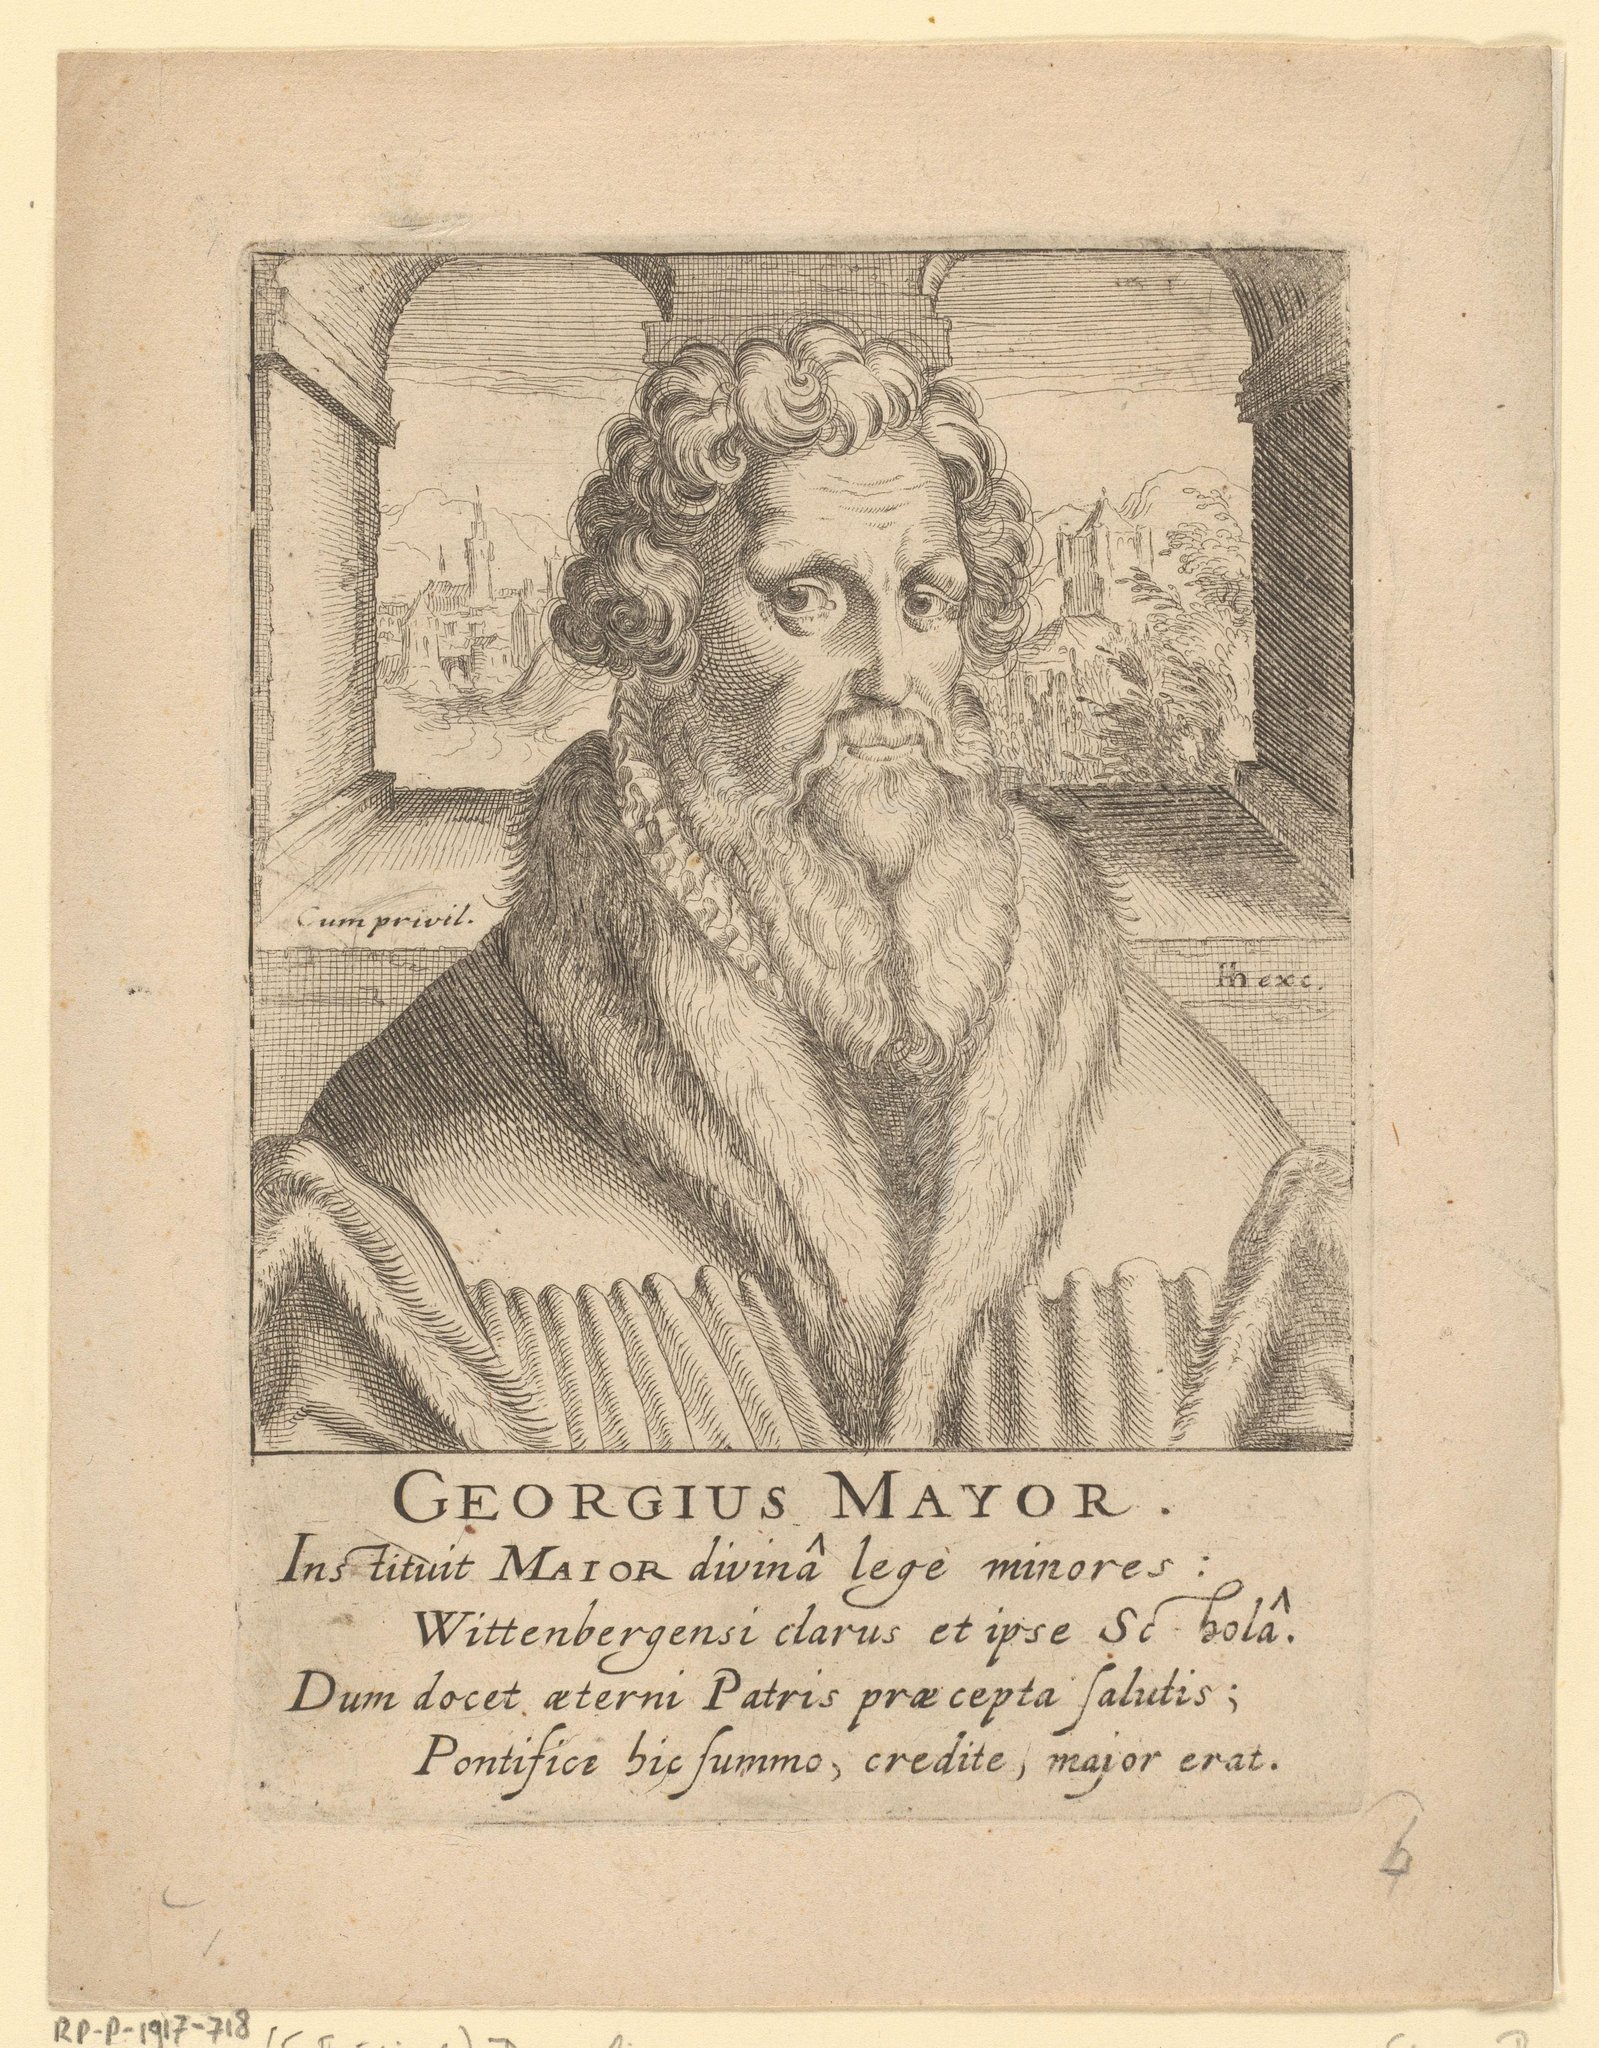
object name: book illustration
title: Georgius Mayor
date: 1599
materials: paper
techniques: engraving, etching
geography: the hague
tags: theologian, historical persons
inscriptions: collector's mark: Lugt 2228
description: Prent mogelijk gebruikt in: Hondius, Hendrick. Icones virorum nostra patrumque memoria illustrium, quorum opera cum literatum studia, tum vera religio fuit restaurata. Den Haag: Hendrick Hondius, 1599, vol. 2.